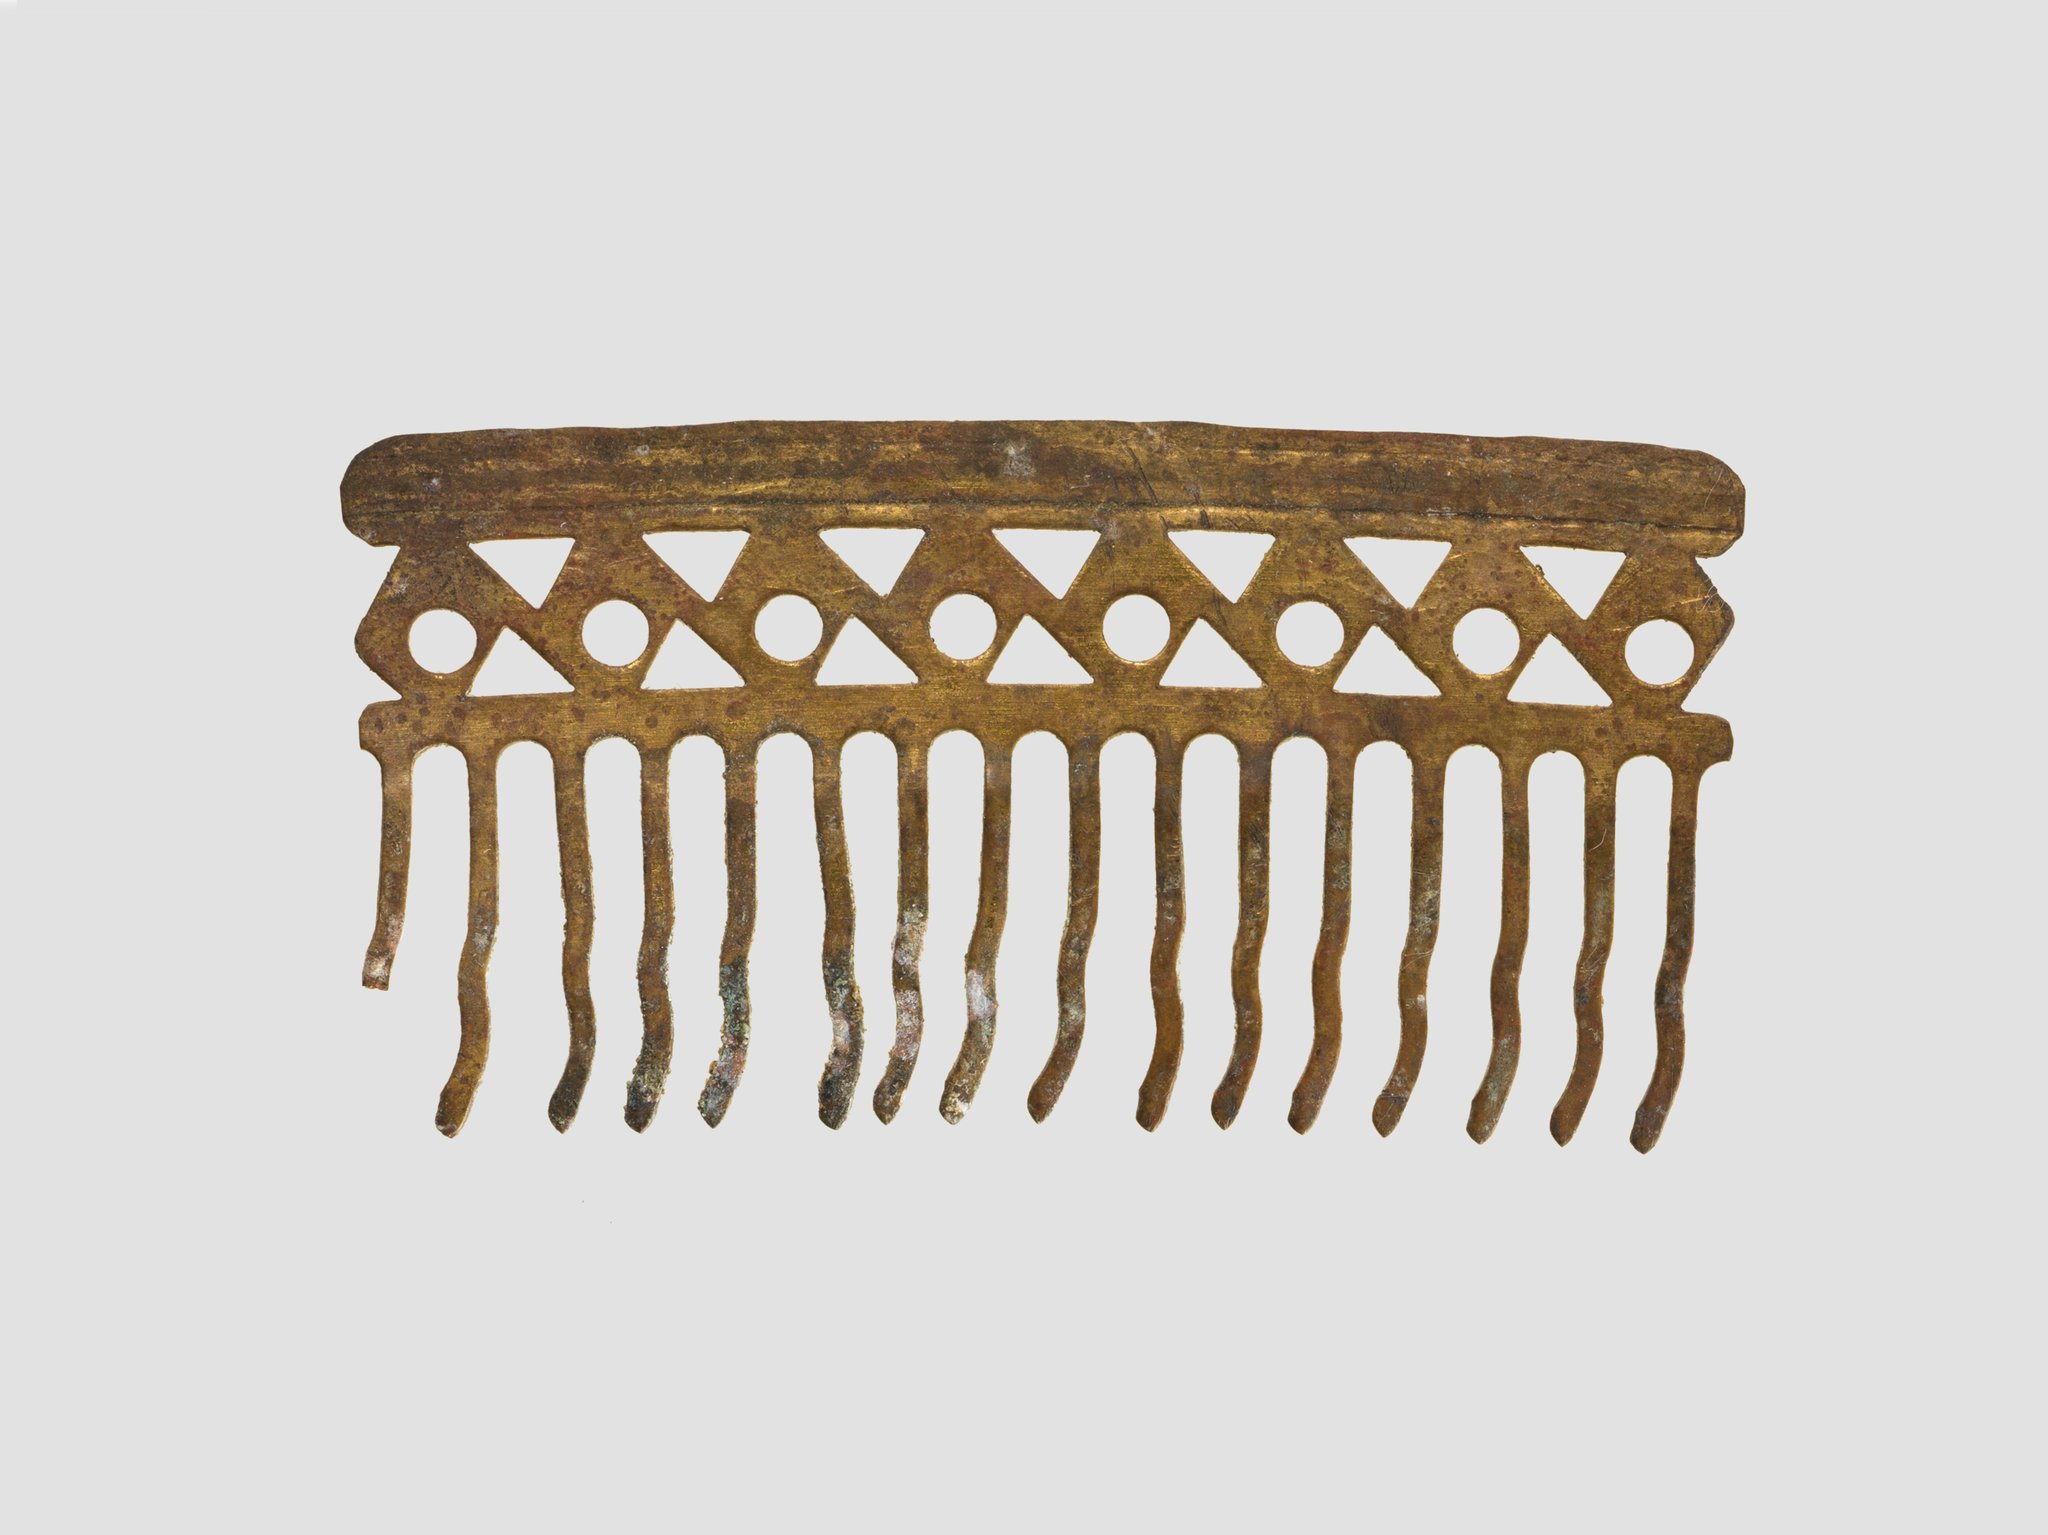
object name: comb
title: Bronze comb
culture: alanic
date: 601-900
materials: bronze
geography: caucasus